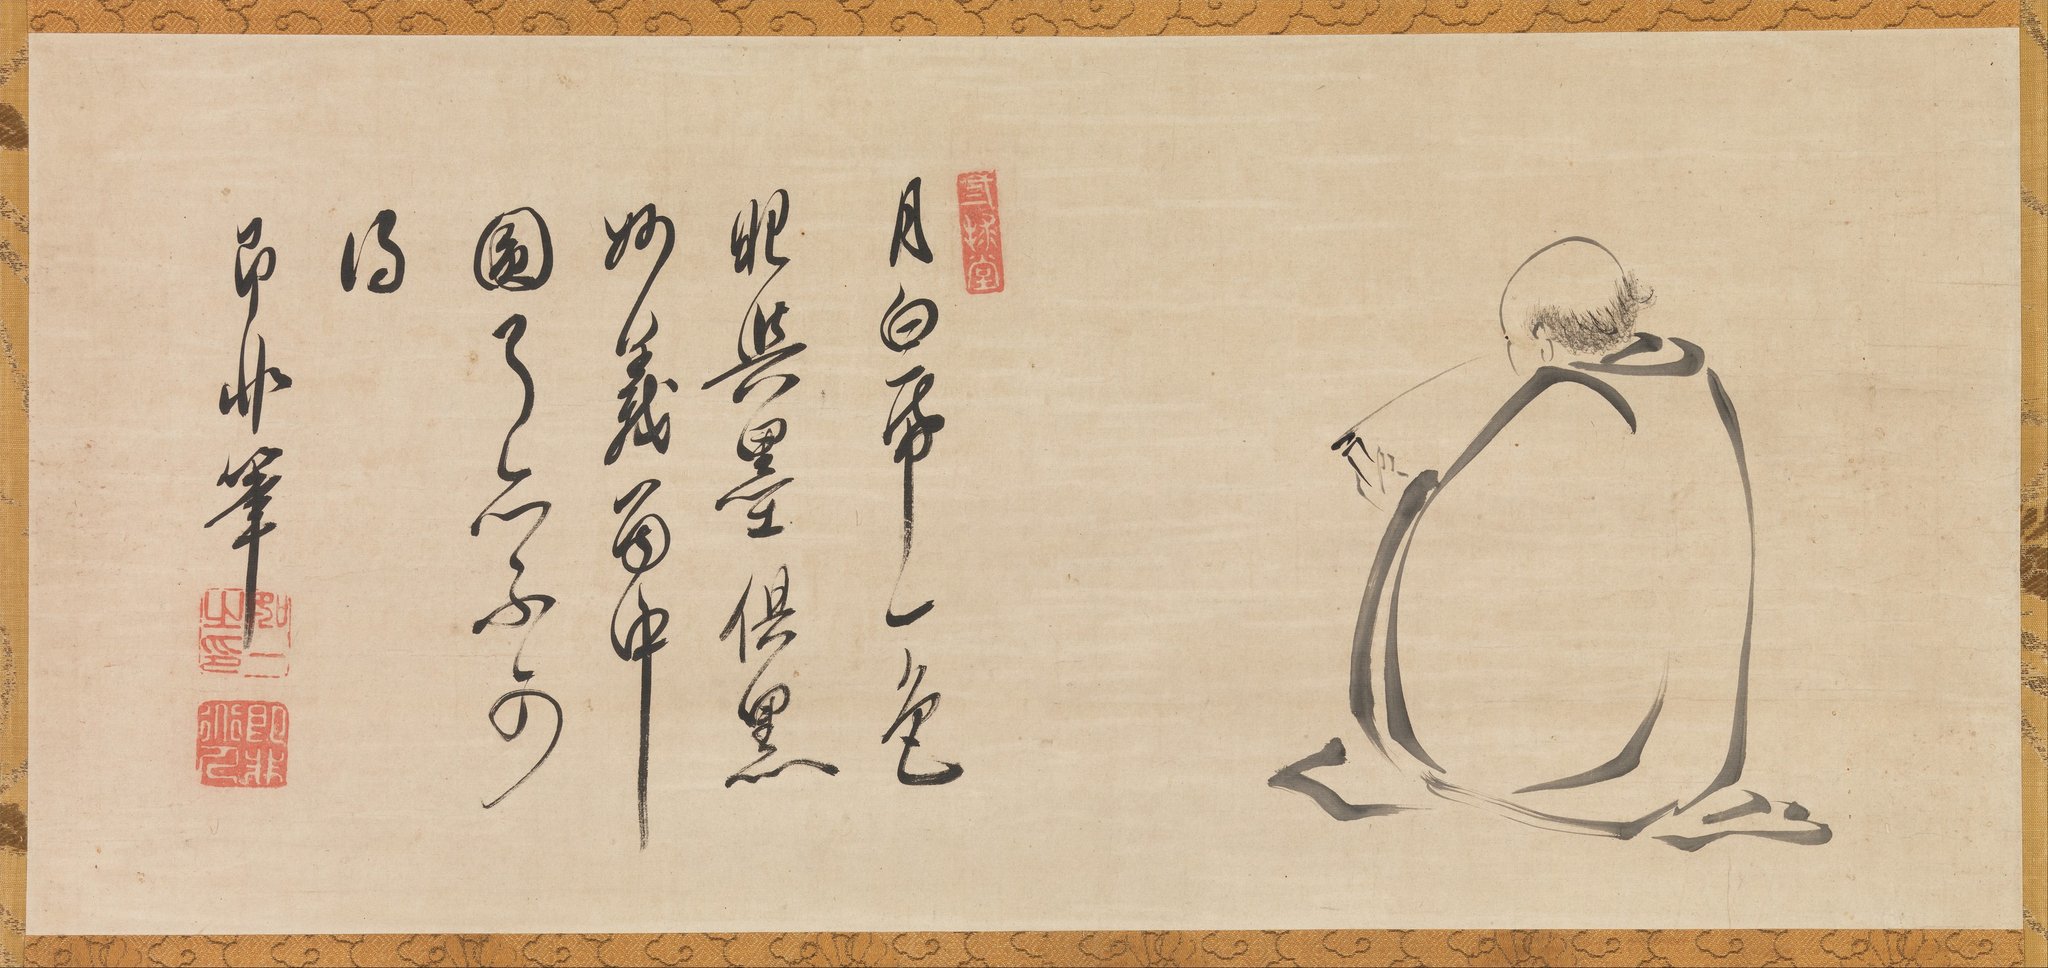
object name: hanging scroll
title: Reading a Sutra by Moonlight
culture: japanese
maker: jifei ruyi (sokuhi nyoitsu)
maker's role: artist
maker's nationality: chinese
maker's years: 1616-1671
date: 1601-1700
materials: ink, paper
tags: men,reading